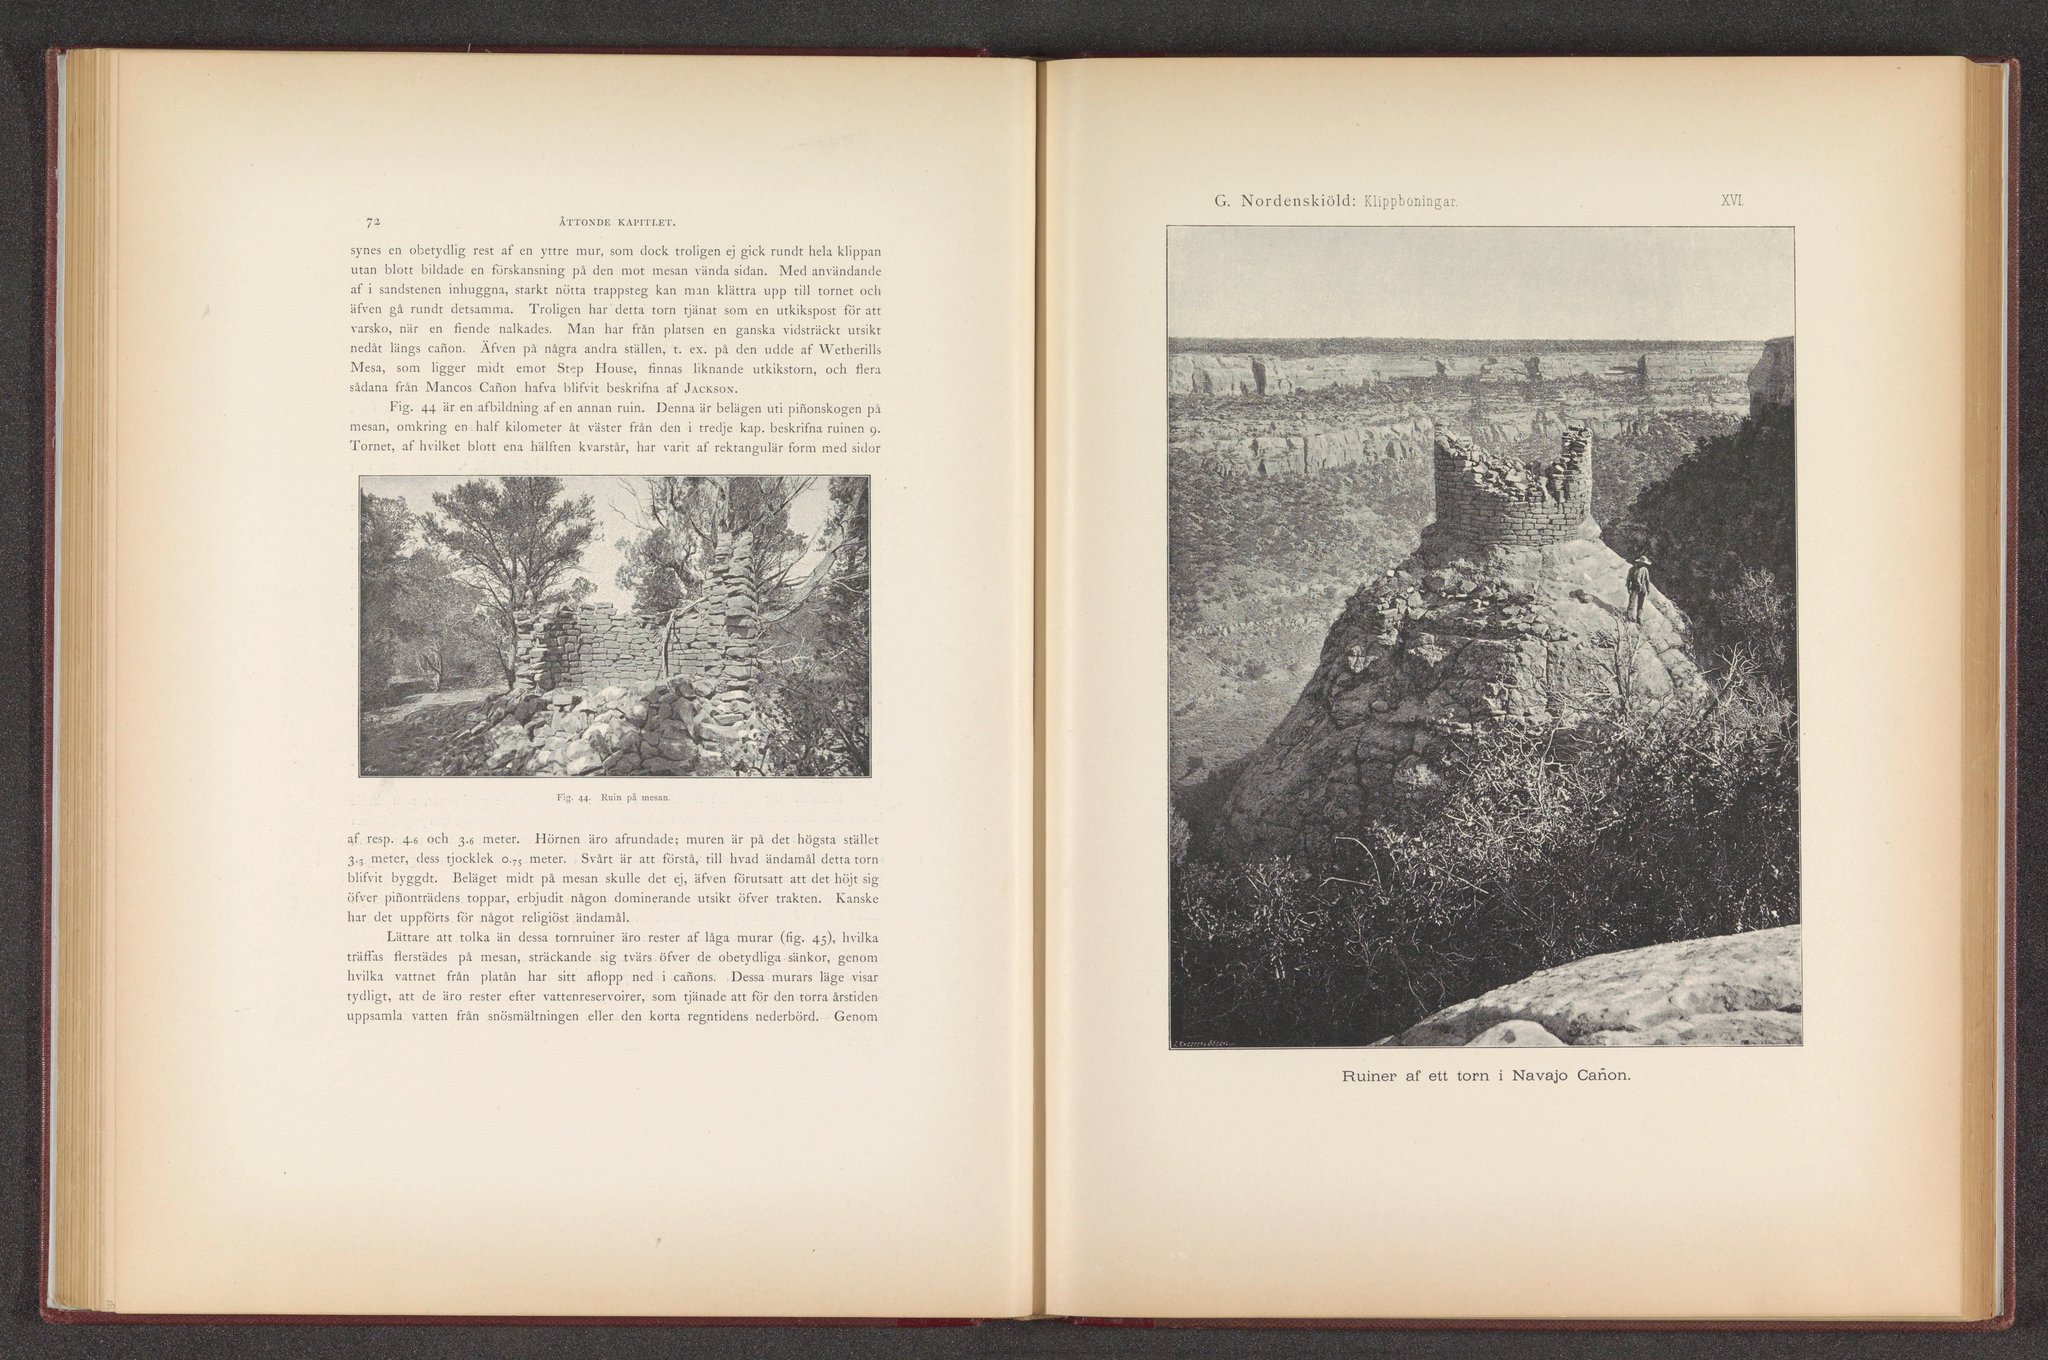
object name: page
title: Ruiner af ett torn i Navajo Cañon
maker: gustaf nordenskiöld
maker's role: fotograaf, schrijver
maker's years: 1868-1895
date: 1891-1893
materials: paper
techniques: autotype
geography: vienna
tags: ruin of a building ~ architecture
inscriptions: number: ‘XVI.’, inscription: ‘G. Nordenskiöld: Klippboningar.’